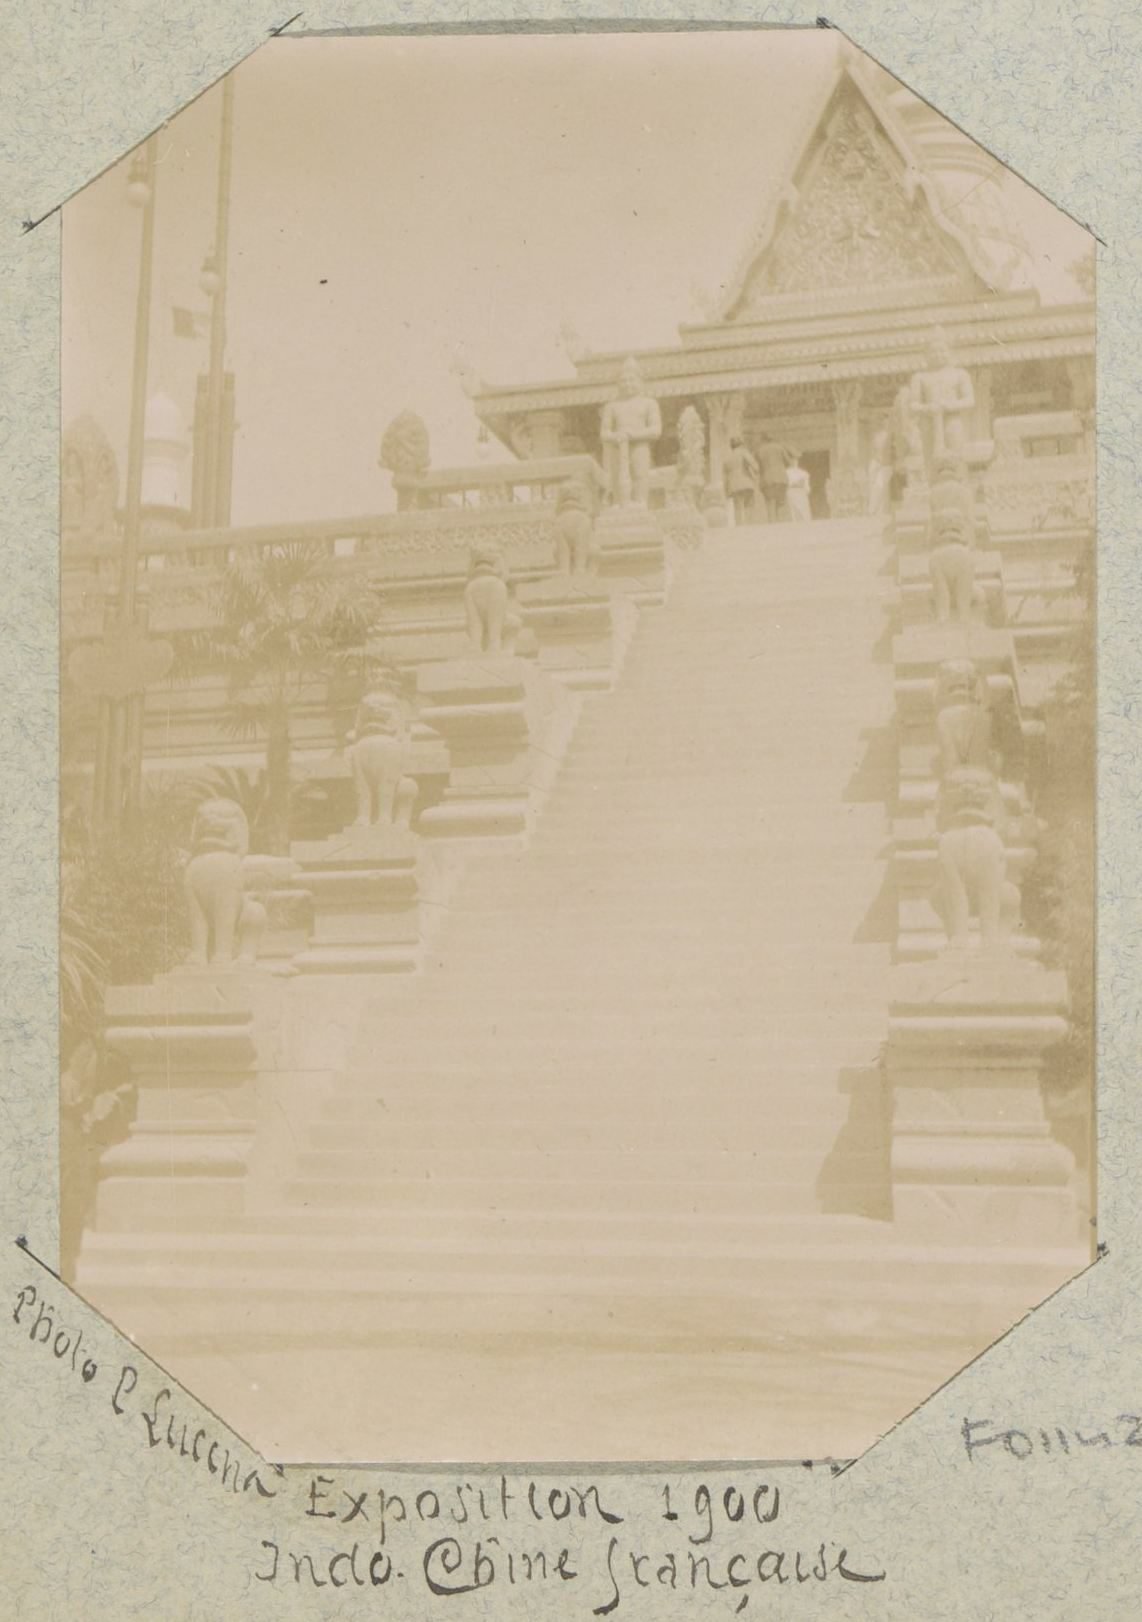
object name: photograph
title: Gezicht op het paviljoen van Frans Indochina tijdens de Wereldtentoonstelling van 1900 in Parijs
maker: paul lucena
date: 1900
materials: paper, photographic support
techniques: daylight paper print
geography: paris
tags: world fair, world exhibition, palace, paris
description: Onderdeel van Album van een Franse amateur met foto's van Frankrijk, Algerije, Palmyra, de Wereldtentoonstelling van 1900 en van bekende Fransen.